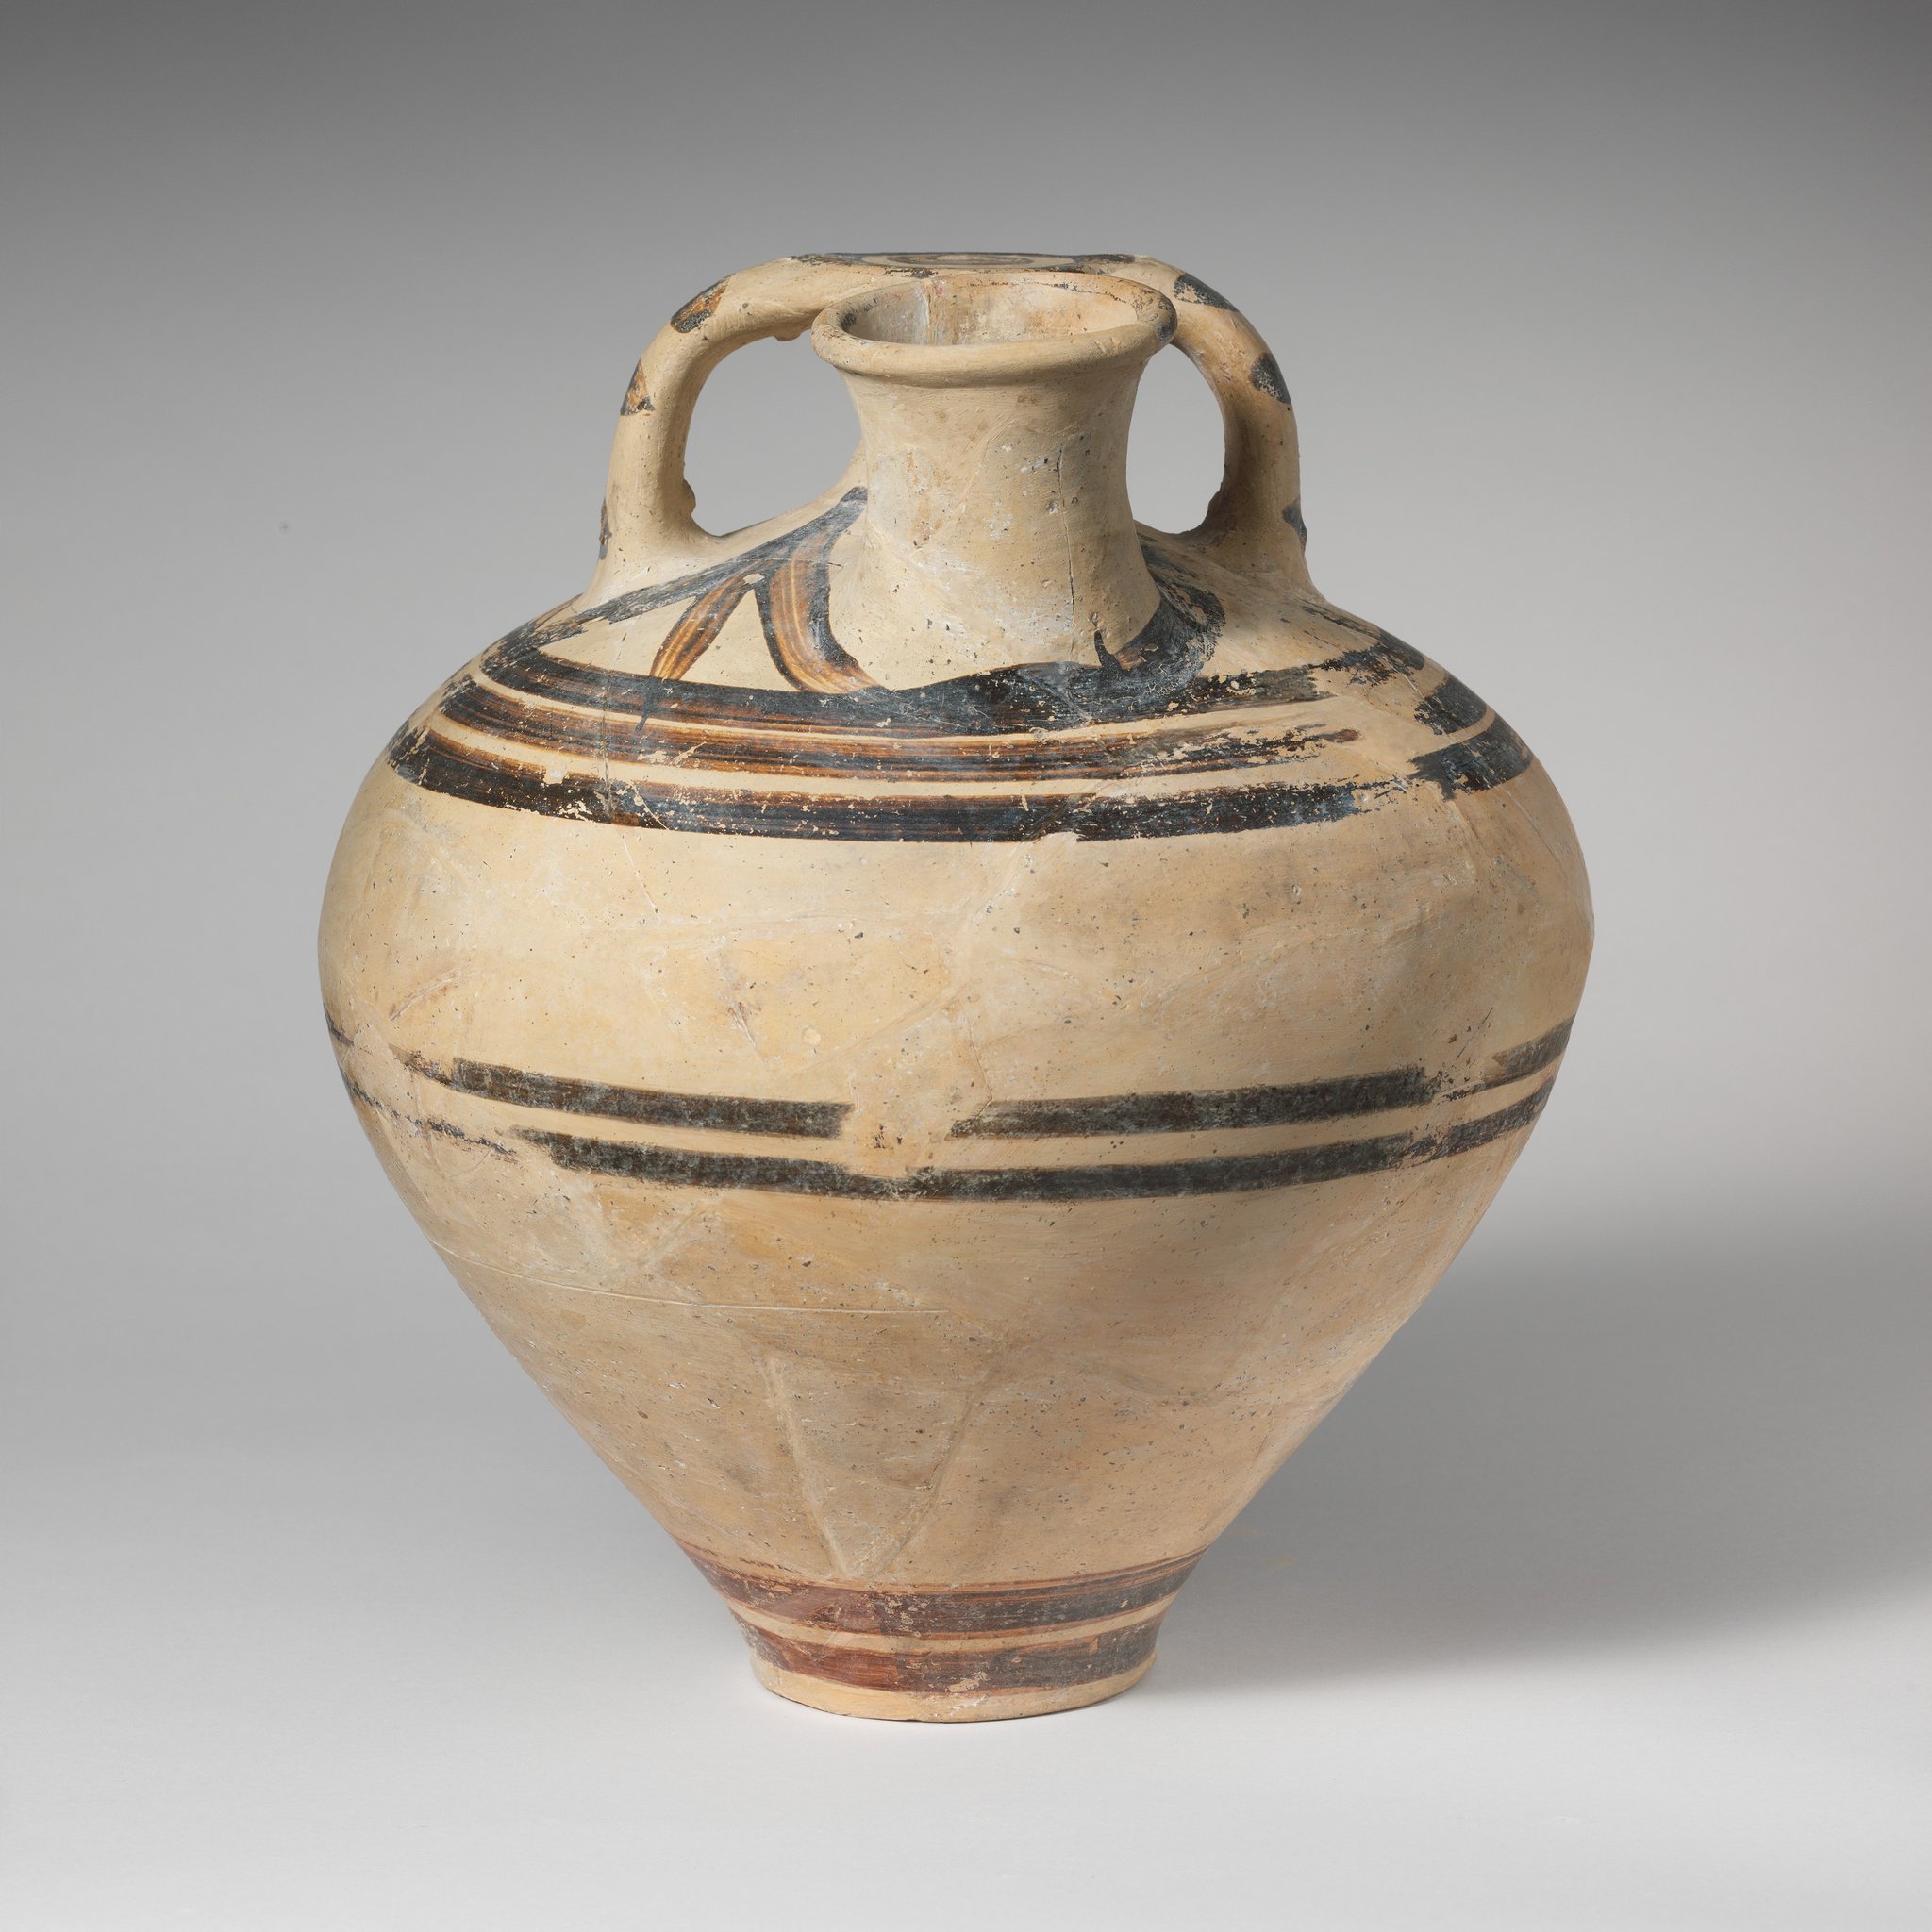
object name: false necked jar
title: Terracotta stirrup jar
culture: mycenaean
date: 1400-1050 BCE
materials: terracotta